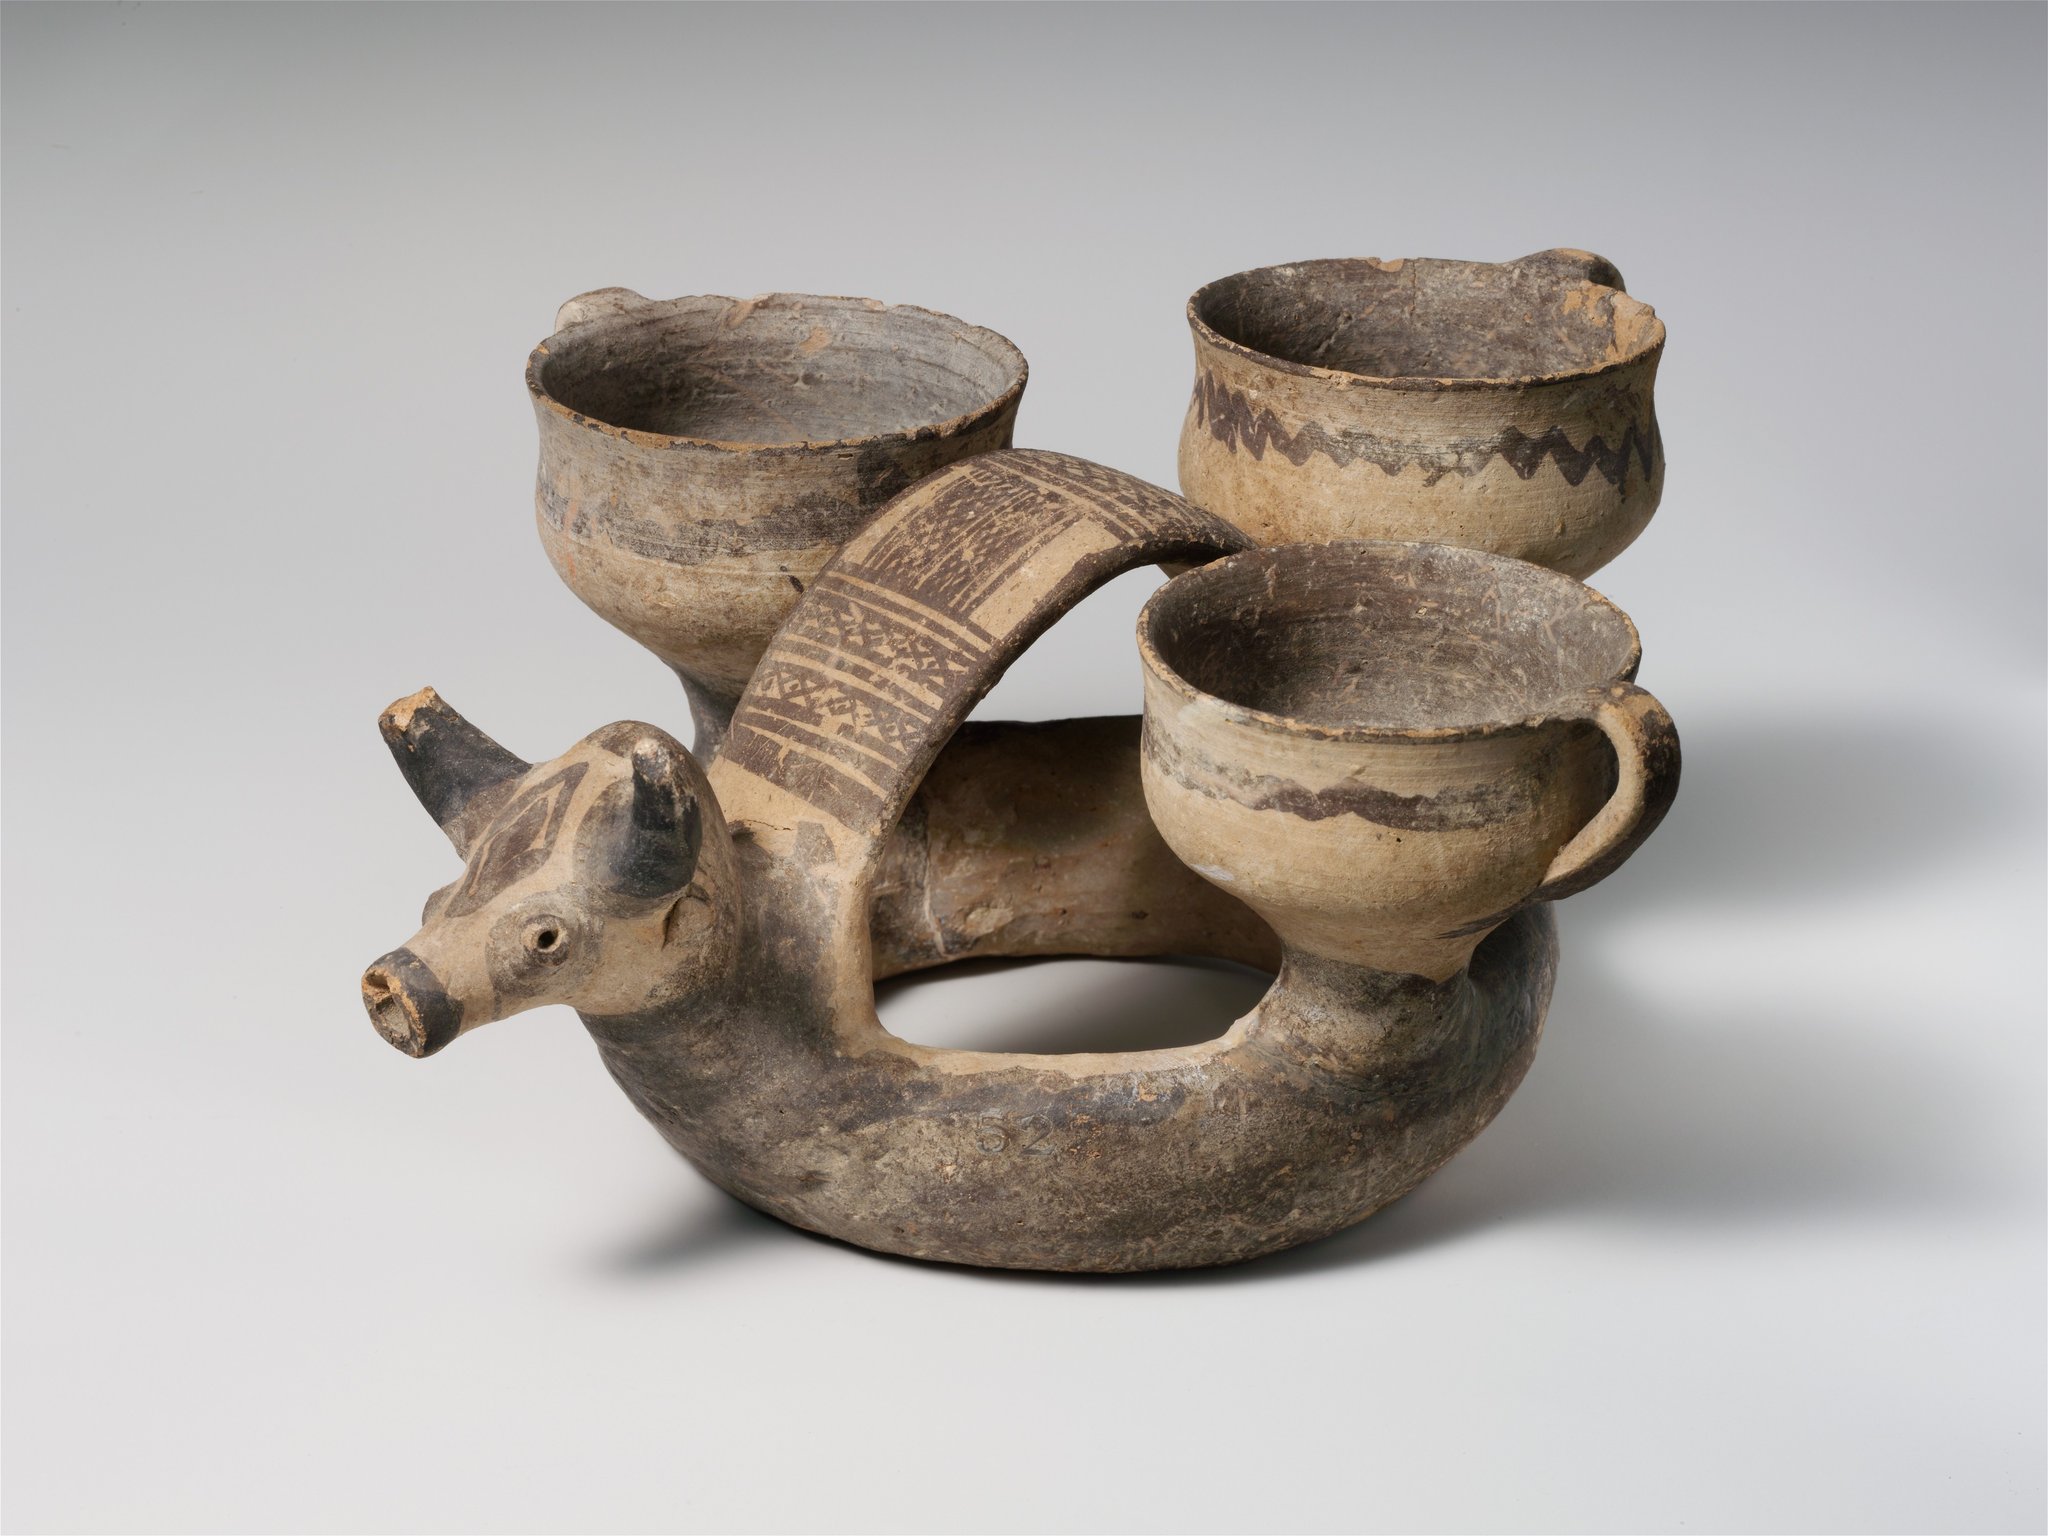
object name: ring kernos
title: Terracotta ring-kernos (offering vase)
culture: cypriot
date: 1050-950 BCE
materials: terracotta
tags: bulls